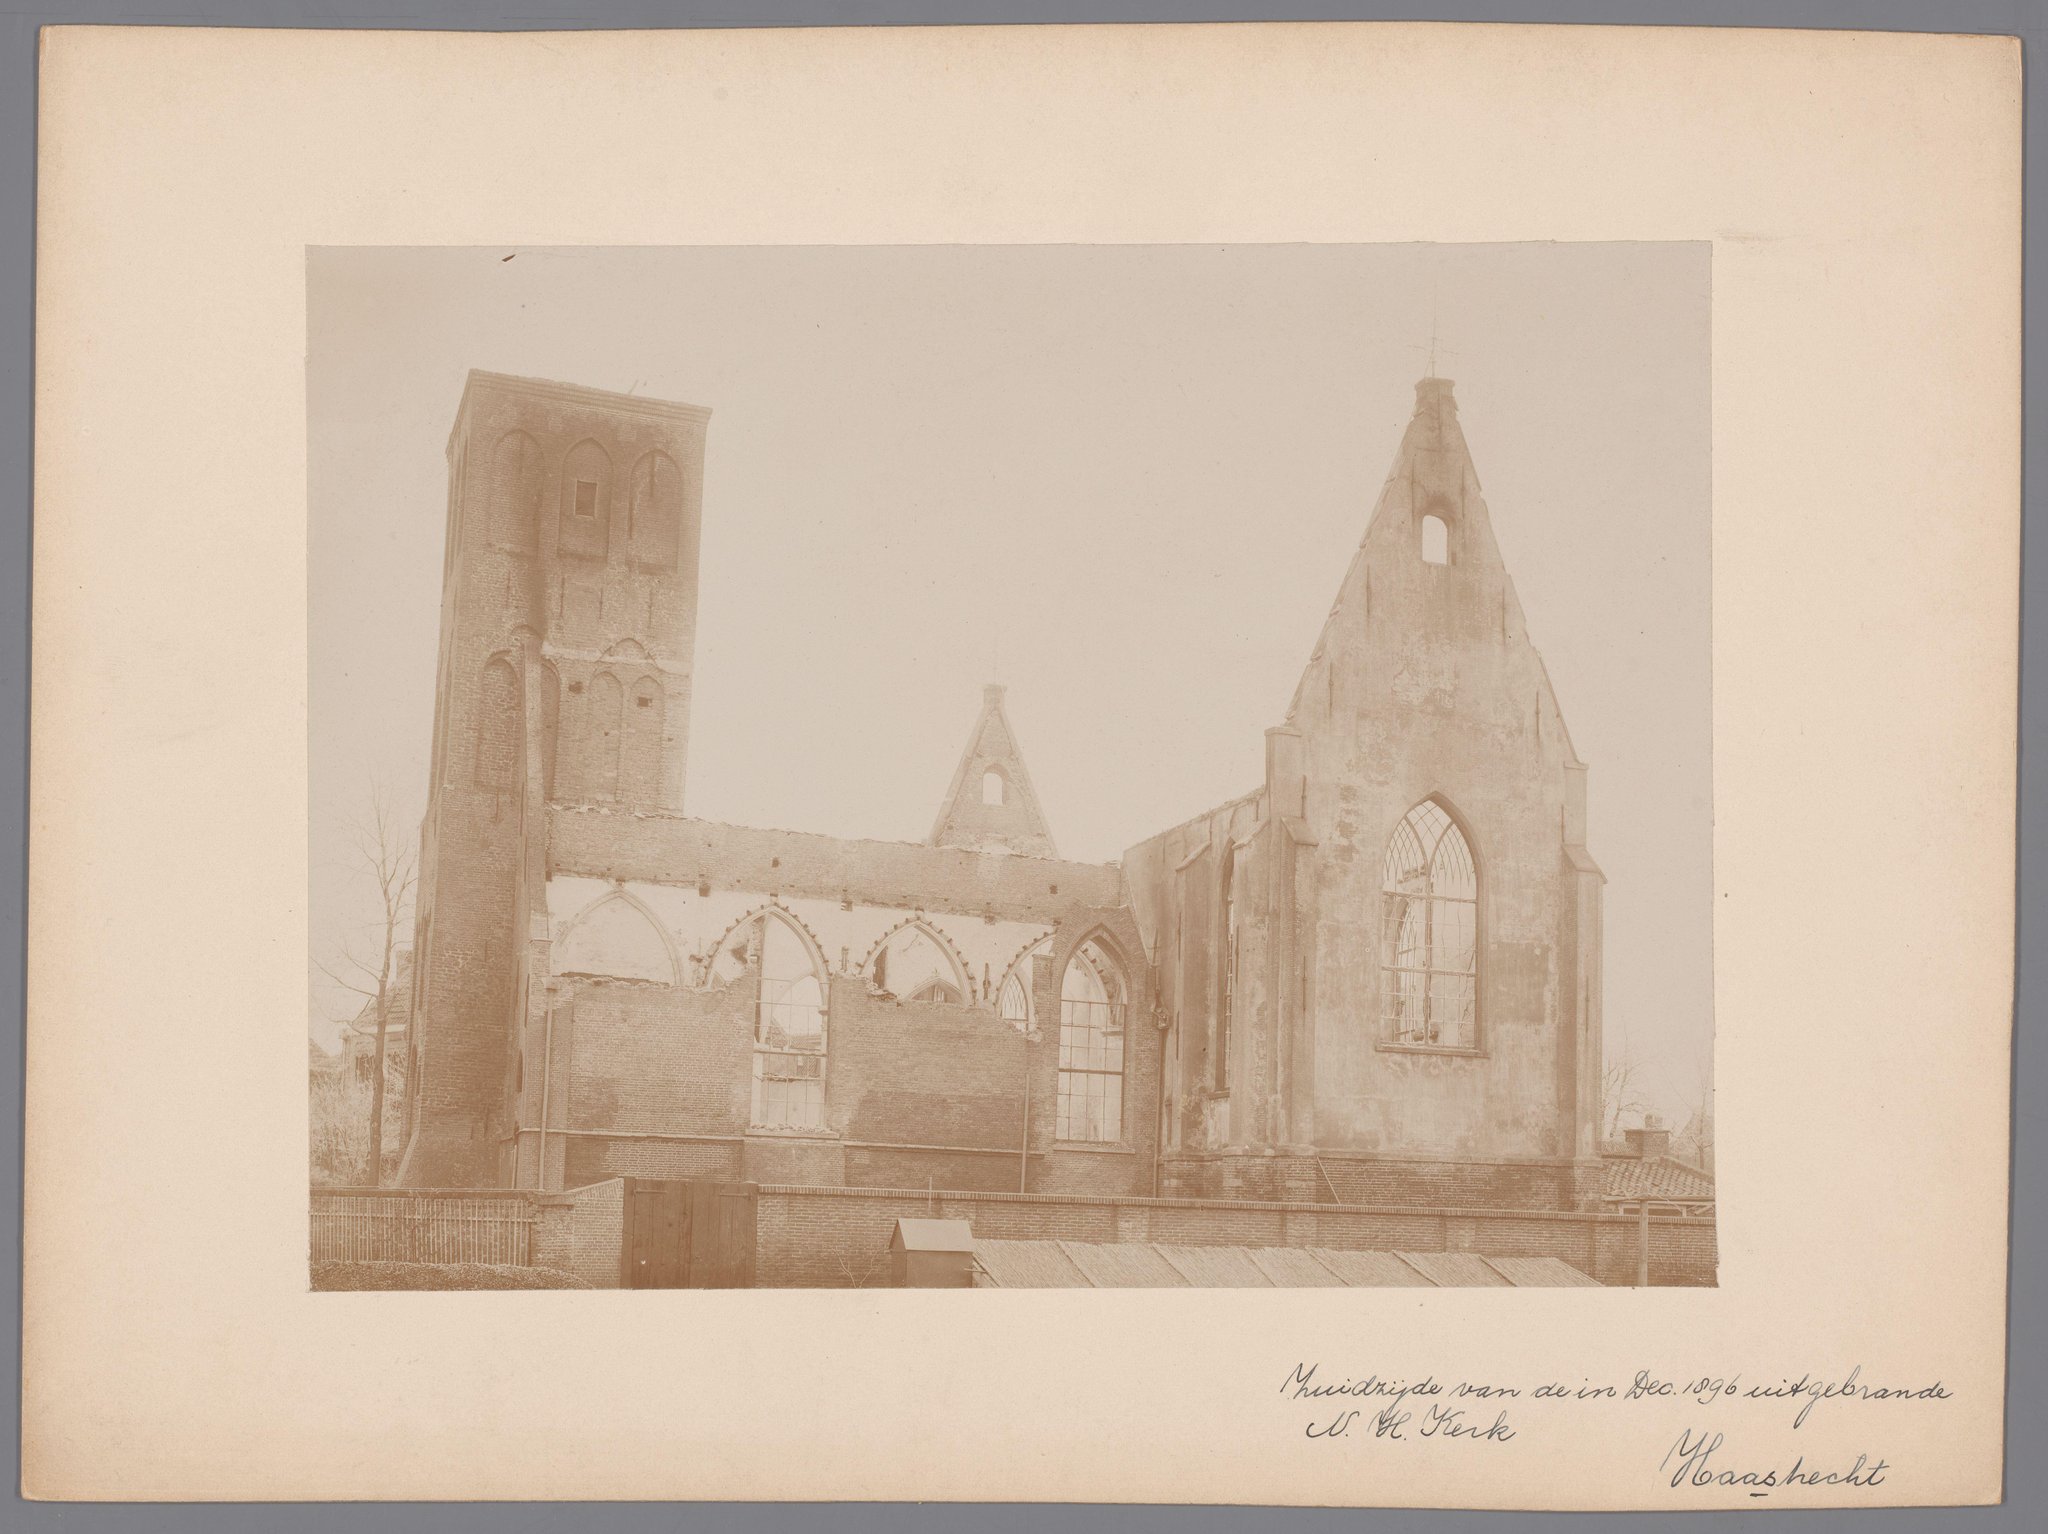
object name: photograph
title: Zuidzijde van de uitgebrande Hervormde Kerk te Haastrecht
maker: anoniem (monumentenzorg)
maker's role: fotograaf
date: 1896-1900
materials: cardboard, photographic support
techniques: collodion silver print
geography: haastrecht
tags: church (exterior)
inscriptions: annotation: ‘Haastrecht (Z.H.)/ Zuidzijde van de in Dec 1896 uitgebrande N.H. Kerk’, annotation: ‘Zuidzijde van de in Dec. 1896 uitgebrande N.H. Kerk/ Haastrecht’